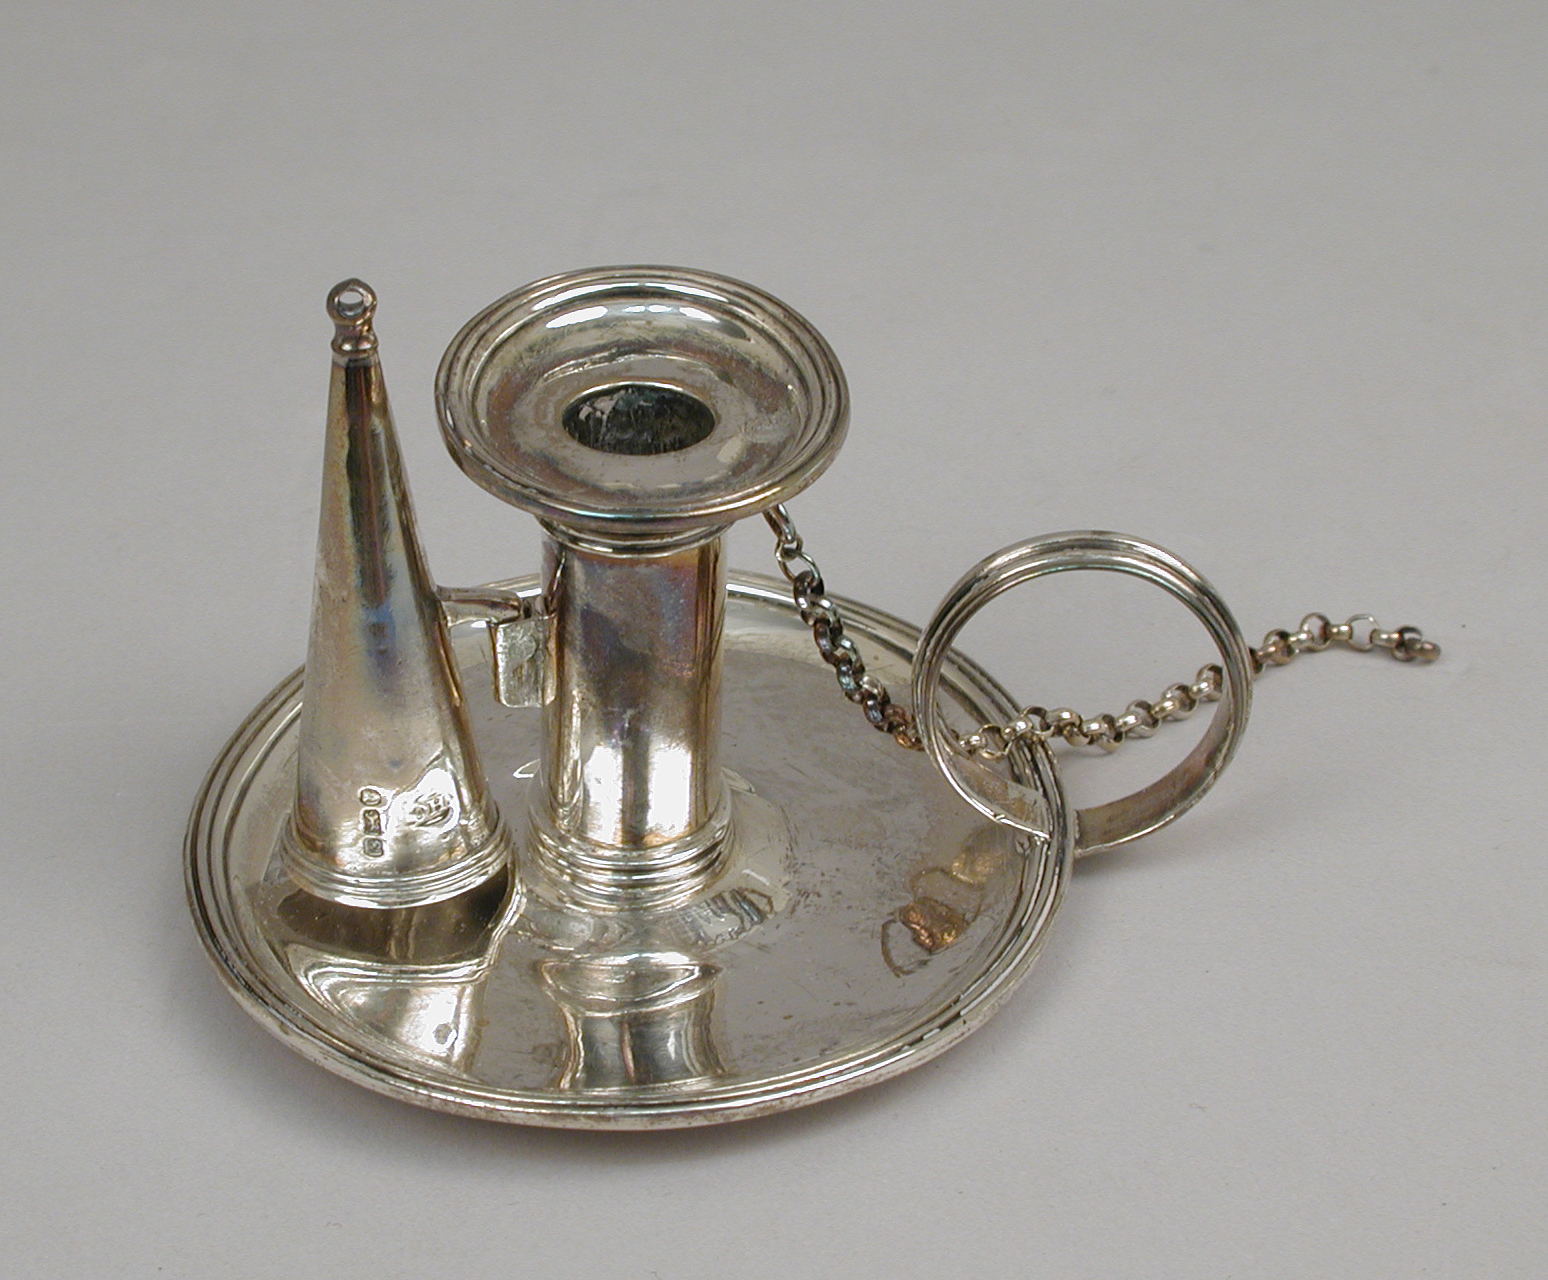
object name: taperstick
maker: henry chawner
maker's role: maker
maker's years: 1750-1850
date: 1793-1794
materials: silver